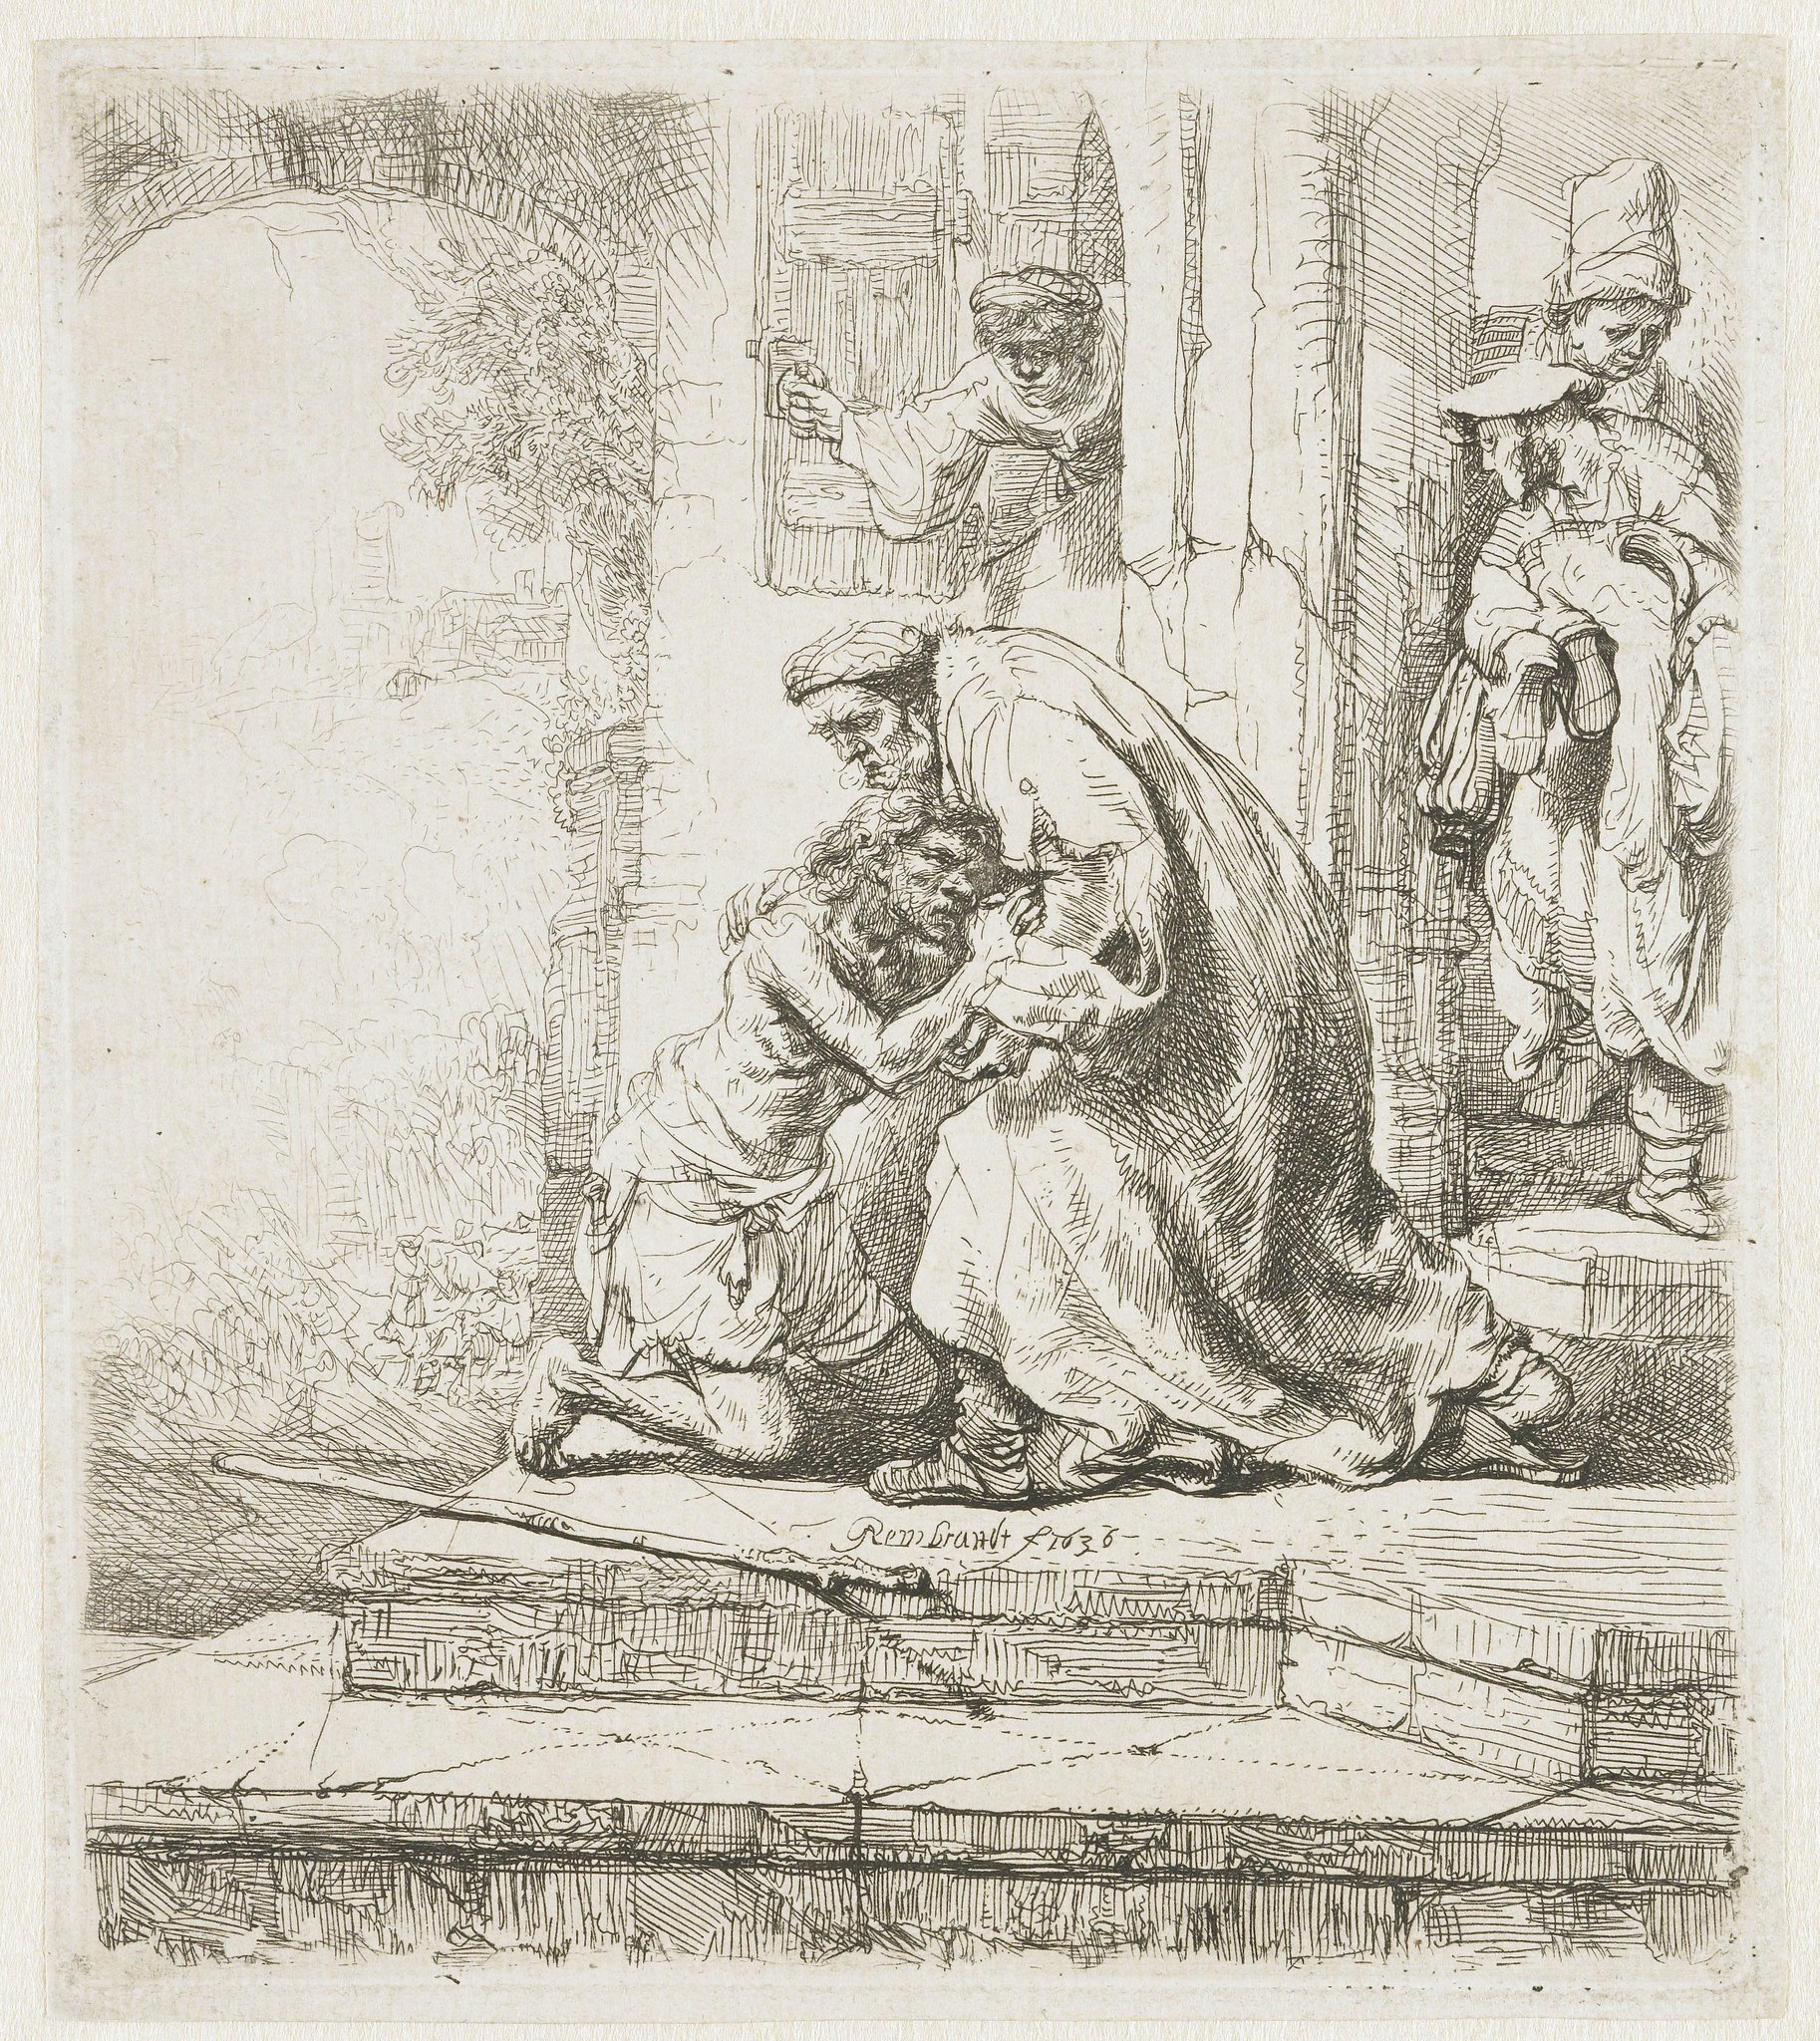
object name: print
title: The return of the prodigal son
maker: rembrandt van rijn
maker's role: draughtsman, painter, print maker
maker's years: 1606-1669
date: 1636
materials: paper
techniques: etching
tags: the parable of the prodigal son (luke 15:11-32)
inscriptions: signature and date: ‘Rembrandt f 1636’ Lugt, mark: 2228 a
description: De terugkeer van de verloren zoon: hij knielt voor zijn vader op het bordes van zijn ouderlijk huis. In de deuropening twee figuren, een derde kijkt uit het venster.